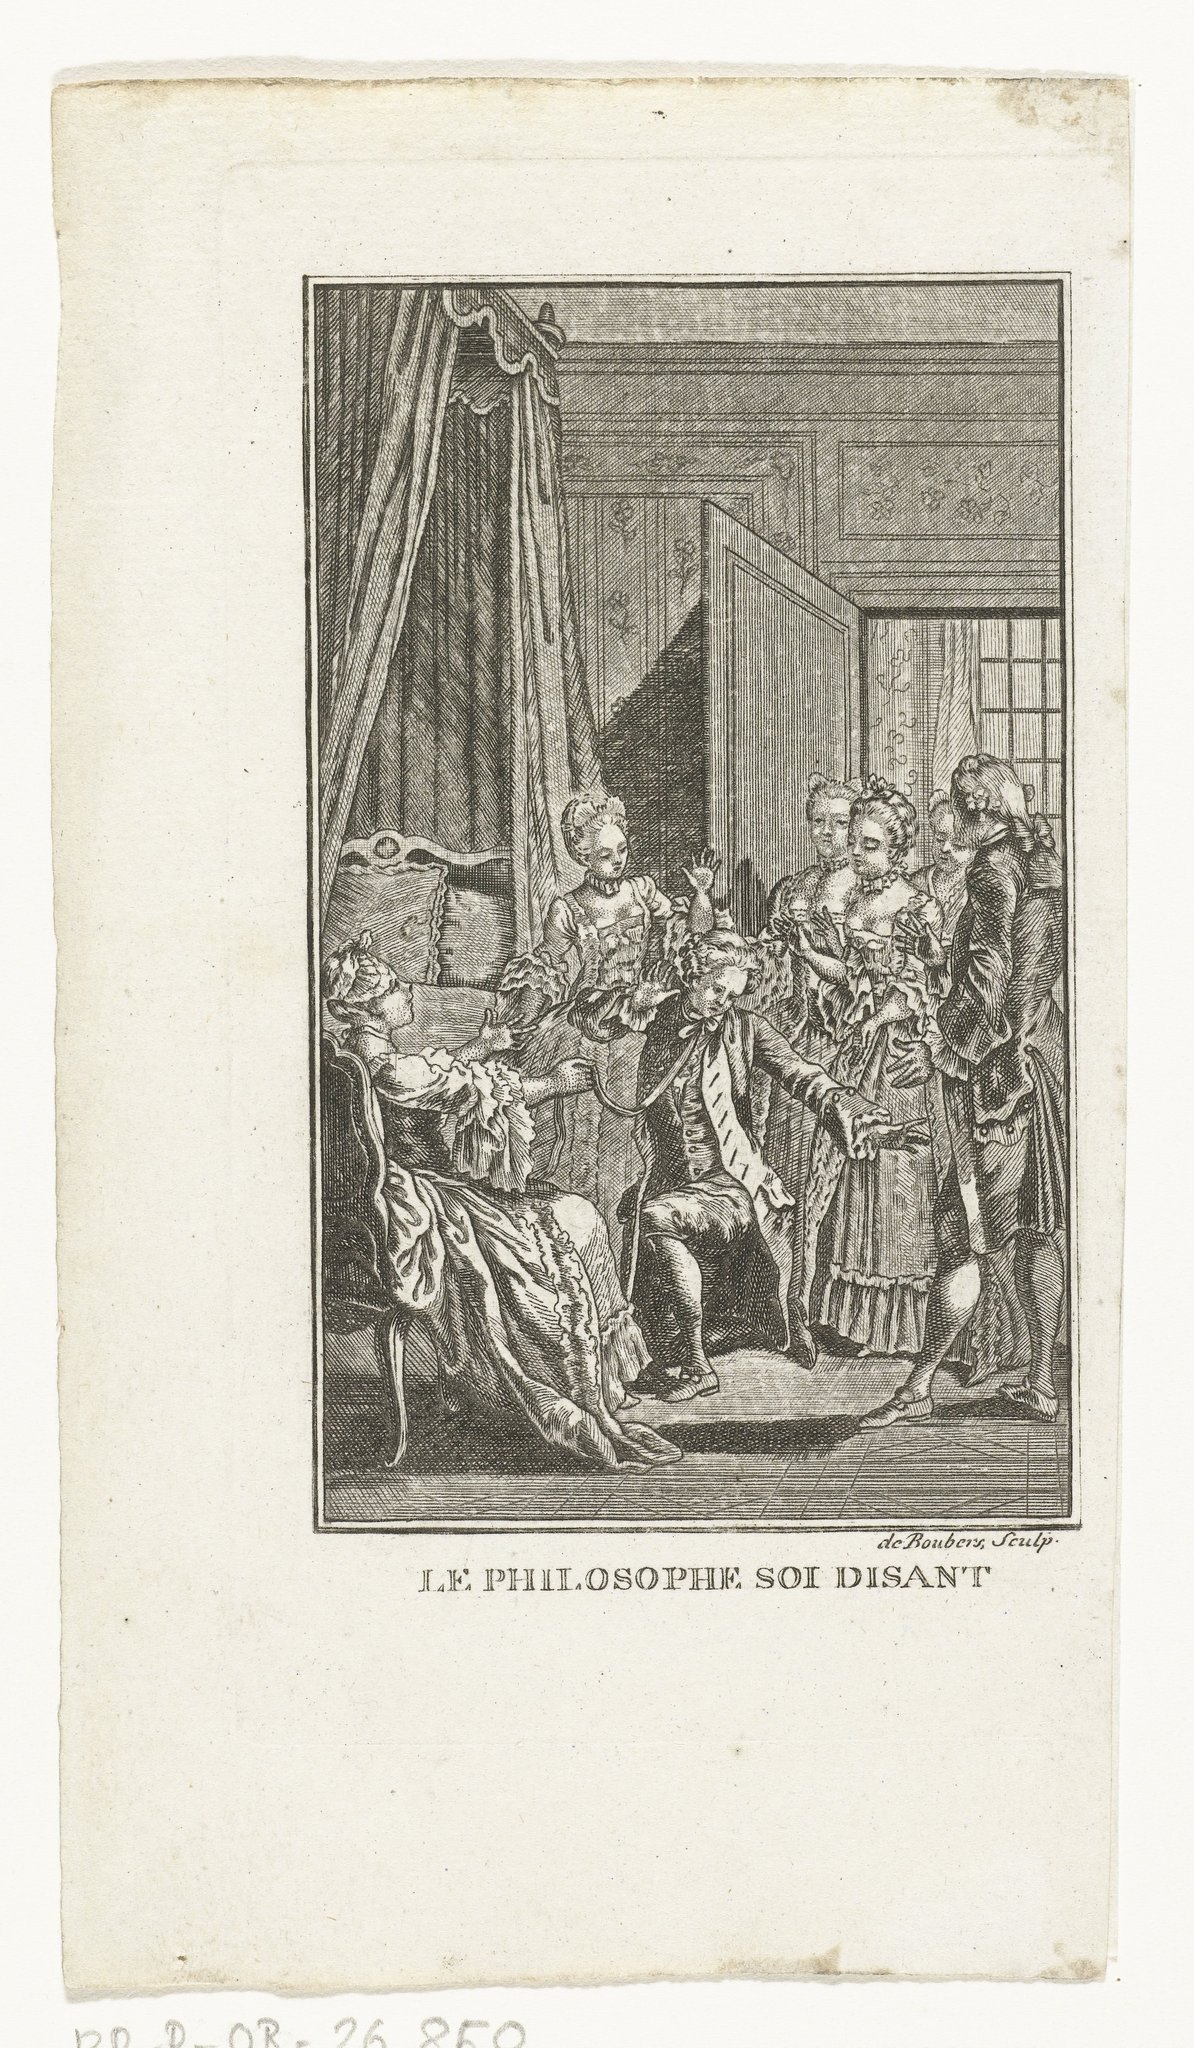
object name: print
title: Le Philosophe soi Disant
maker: n. de boubers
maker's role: print maker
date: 1765-1780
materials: paper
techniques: engraving, etching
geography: paris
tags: scholar, philosopher (+ counterfeit, fake, forgery ~ sciences)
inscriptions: collector's mark: Lugt 2228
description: Illustratie voor het verhaal 'Le Philosophe soi Disant' uit J.F. Marmontel's verhalenbundel 'Contes moreaux'. Een jonge dame, Clarissa, zit in een kamer en ontvangt een man die zich voordoet als filosoof.